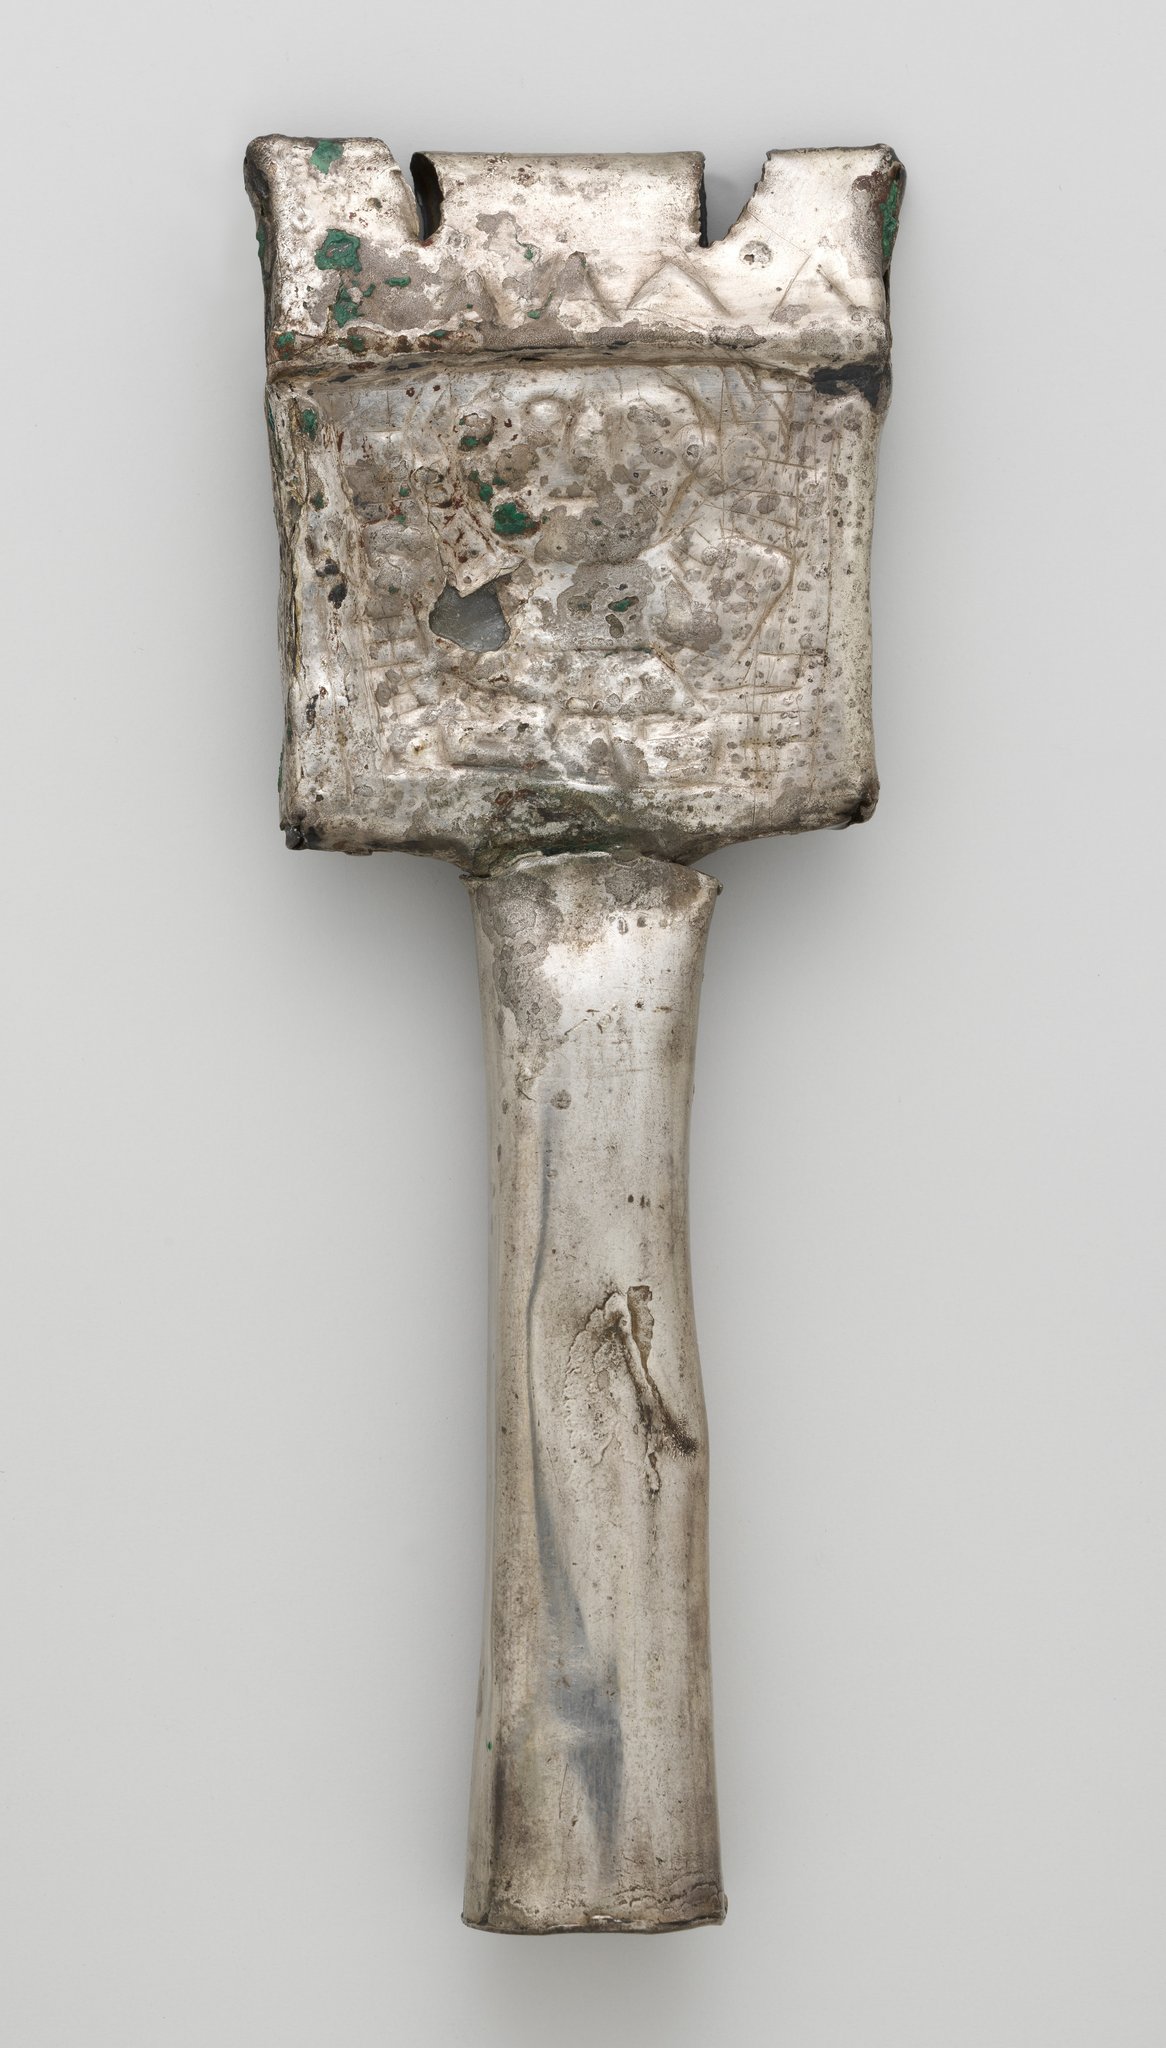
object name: mirror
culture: chancay or chimú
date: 1101-1500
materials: silver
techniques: hammering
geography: peru